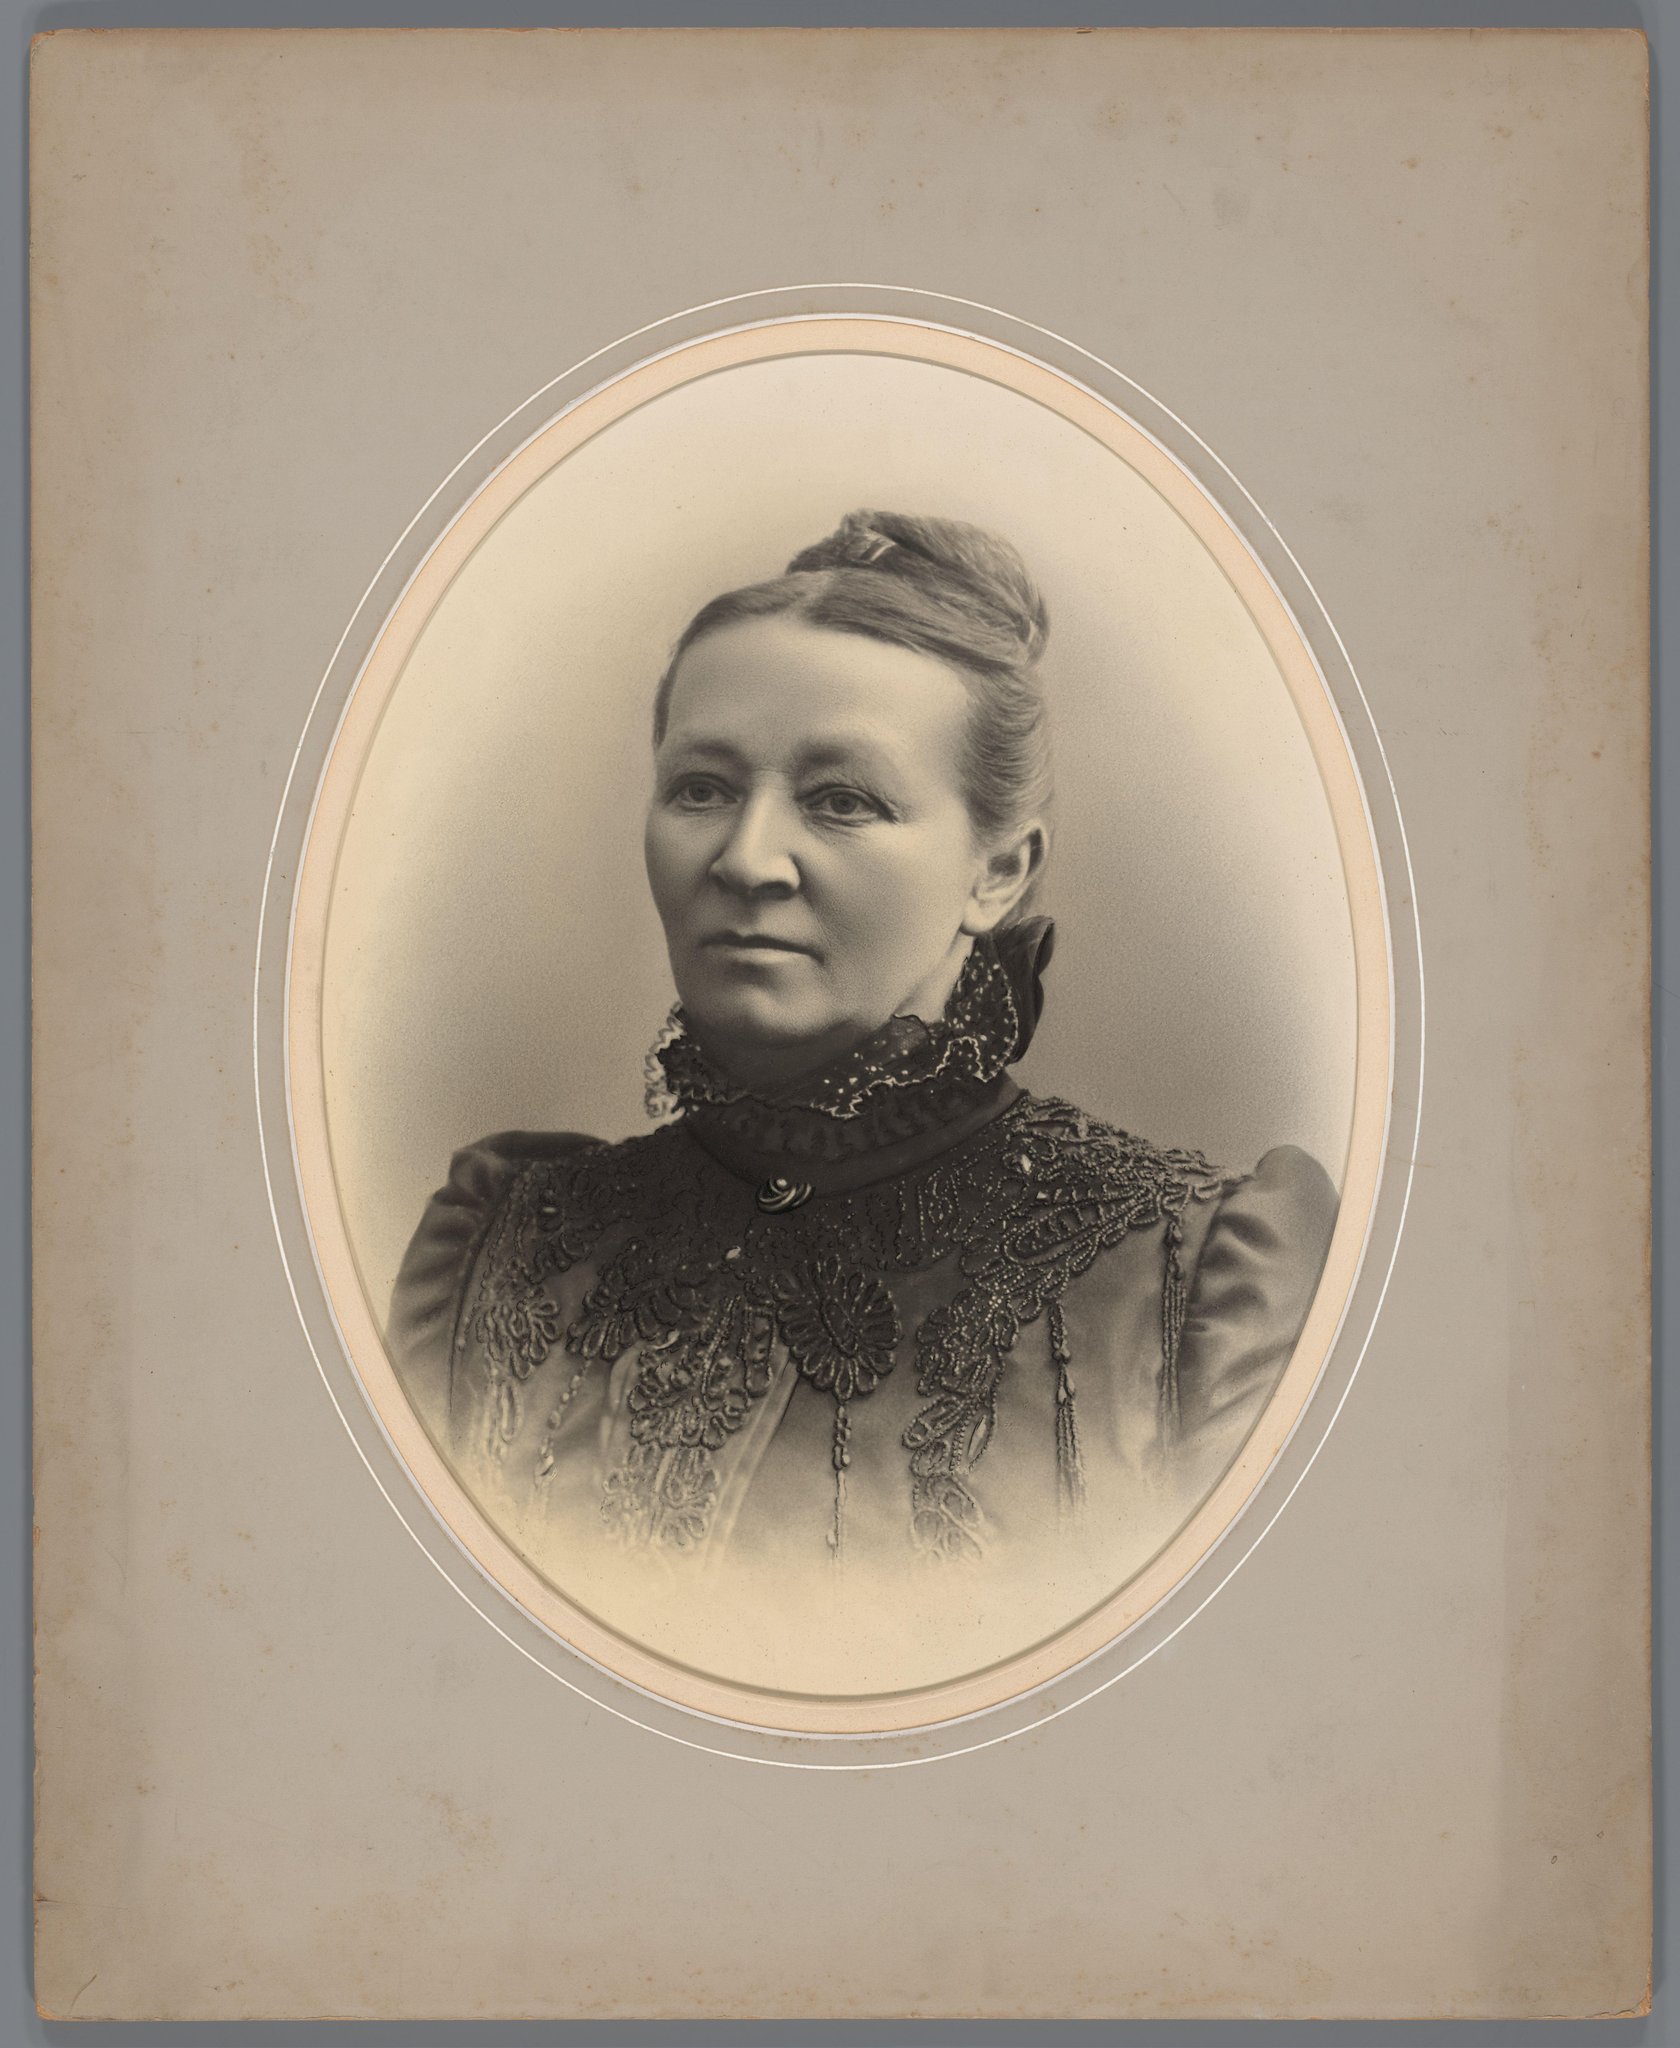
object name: crayon enlargement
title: Portret van een onbekende vrouw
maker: Anonymous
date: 1880-1910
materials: paper, cardboard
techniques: gelatin silver print, retouching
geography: berlin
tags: historical persons not known by name - bb - woman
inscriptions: label: ‘Berli[...]/ Blo[...]/ Hollm[...]’